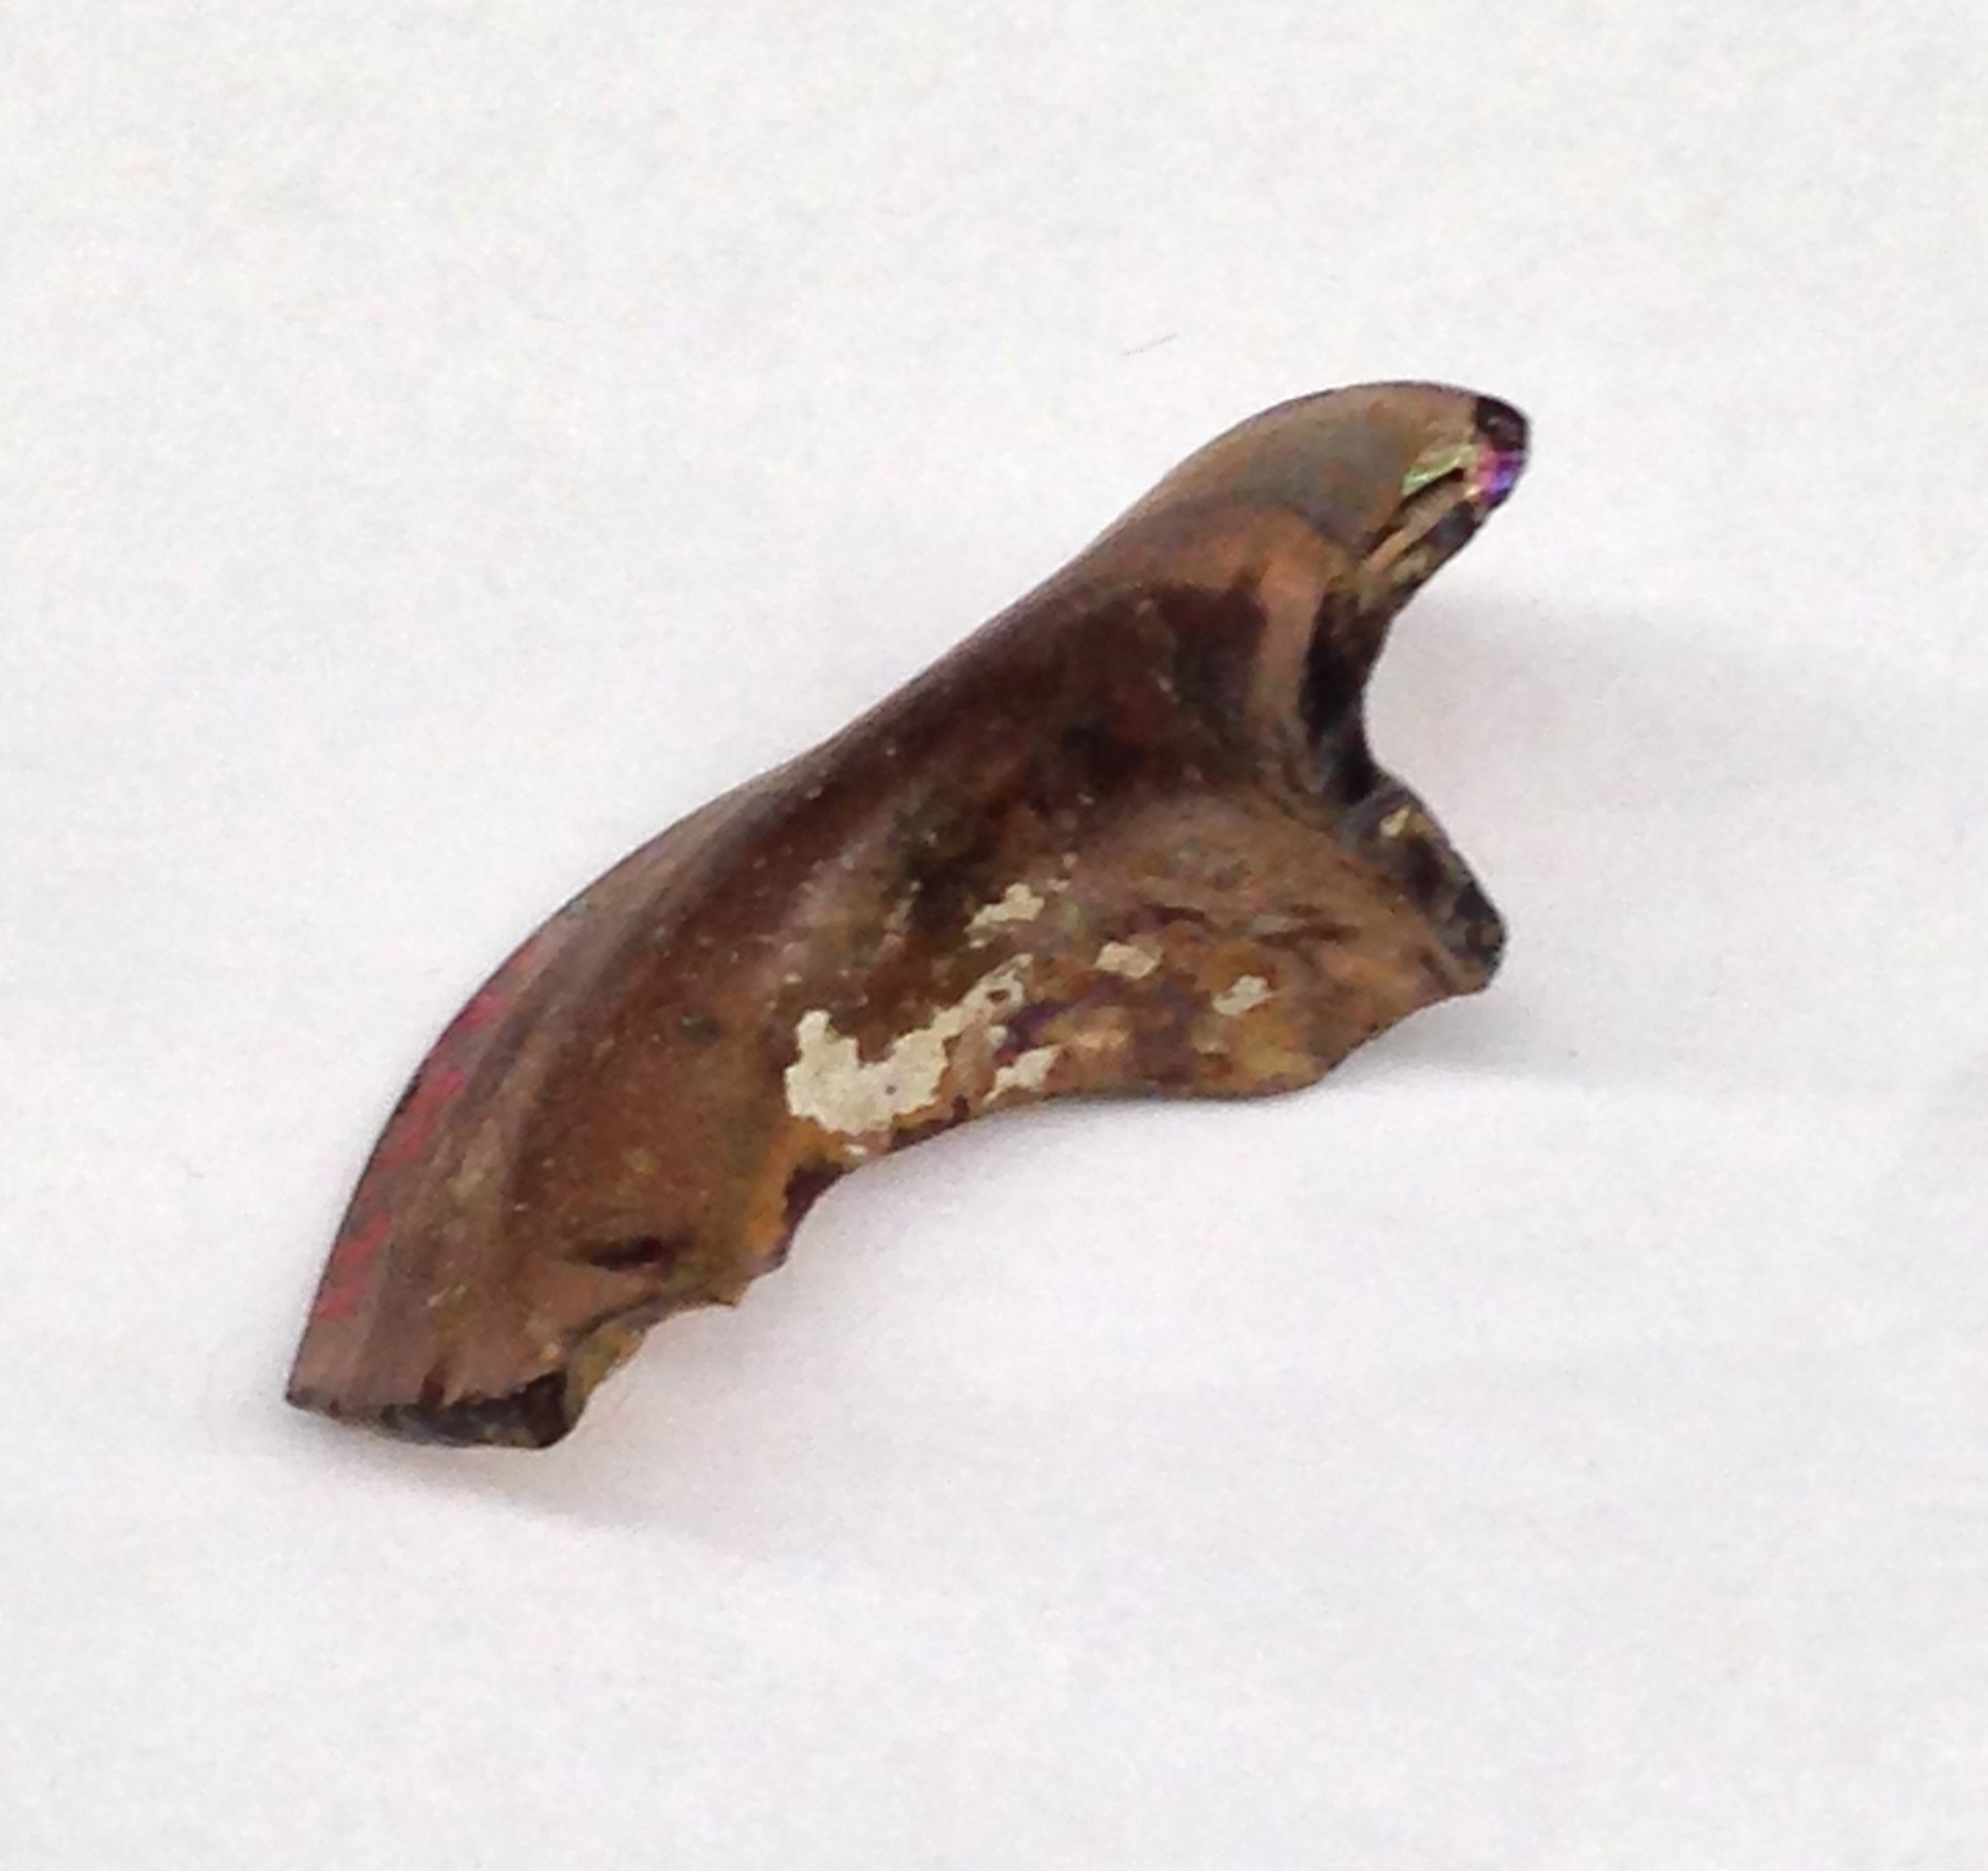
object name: fragment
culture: european or middle eastern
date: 1150-1250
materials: ceramic, glass